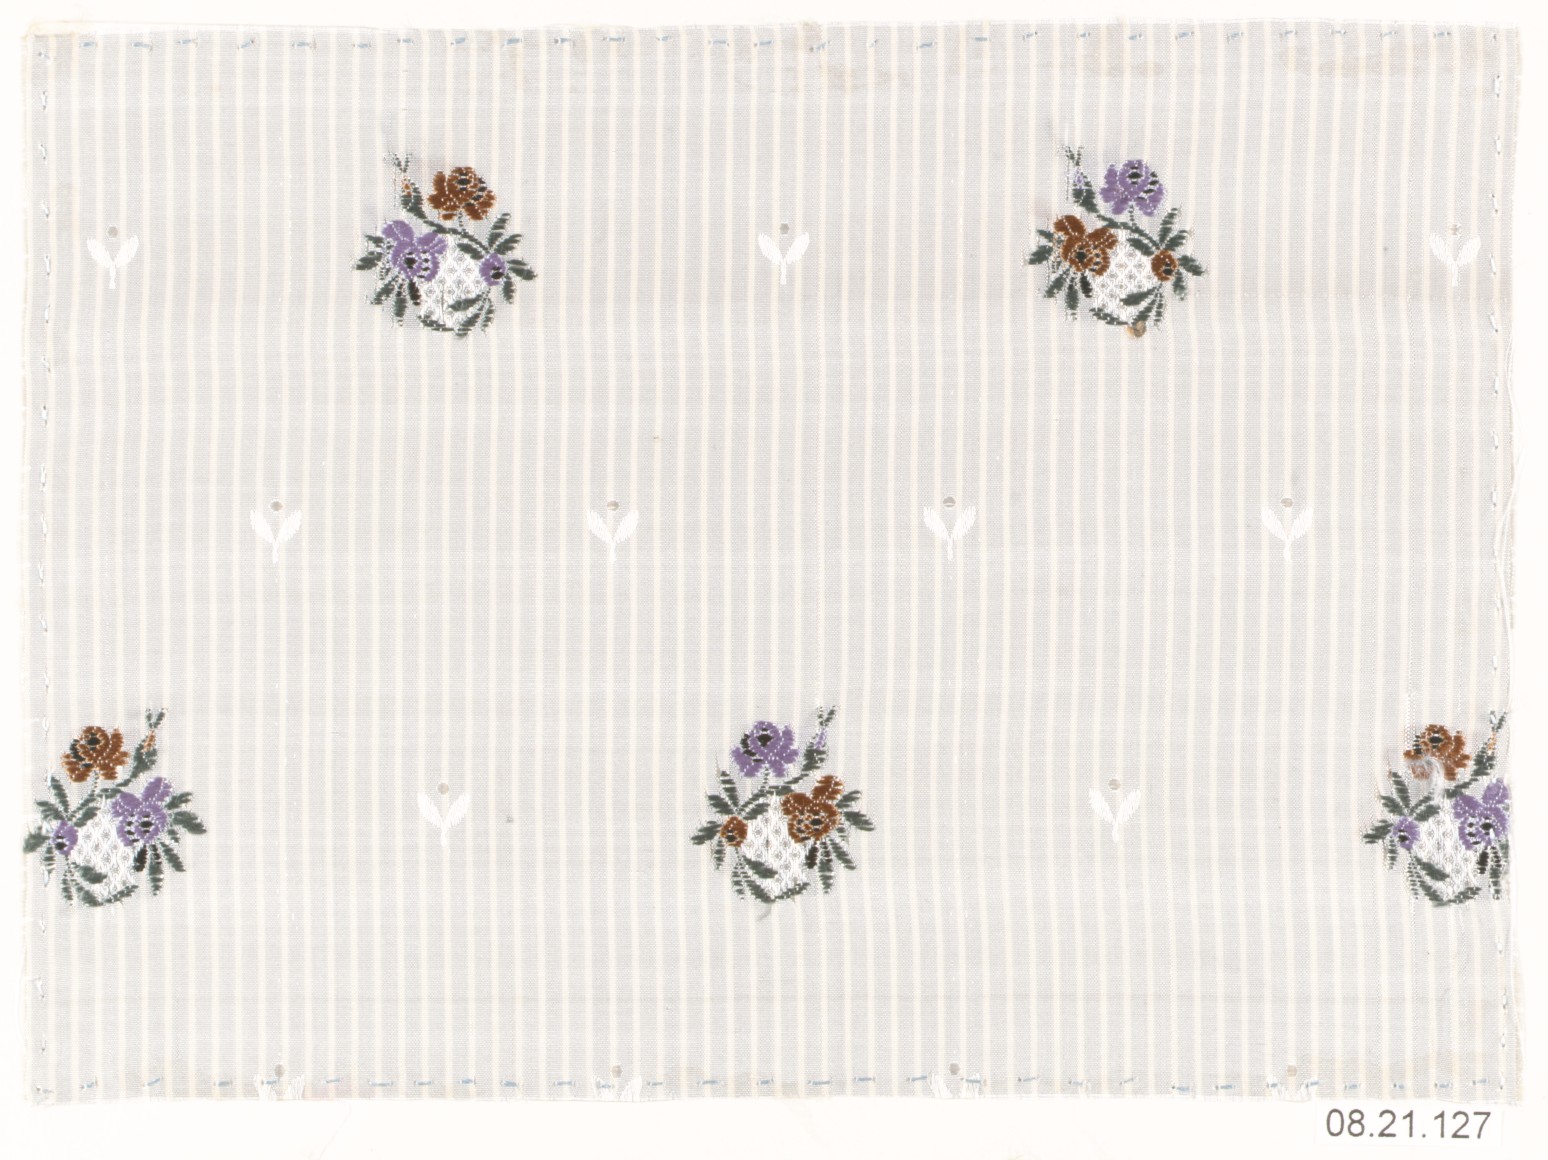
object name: textile sample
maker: Anonymous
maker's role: designer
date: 1900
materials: silk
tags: flowers